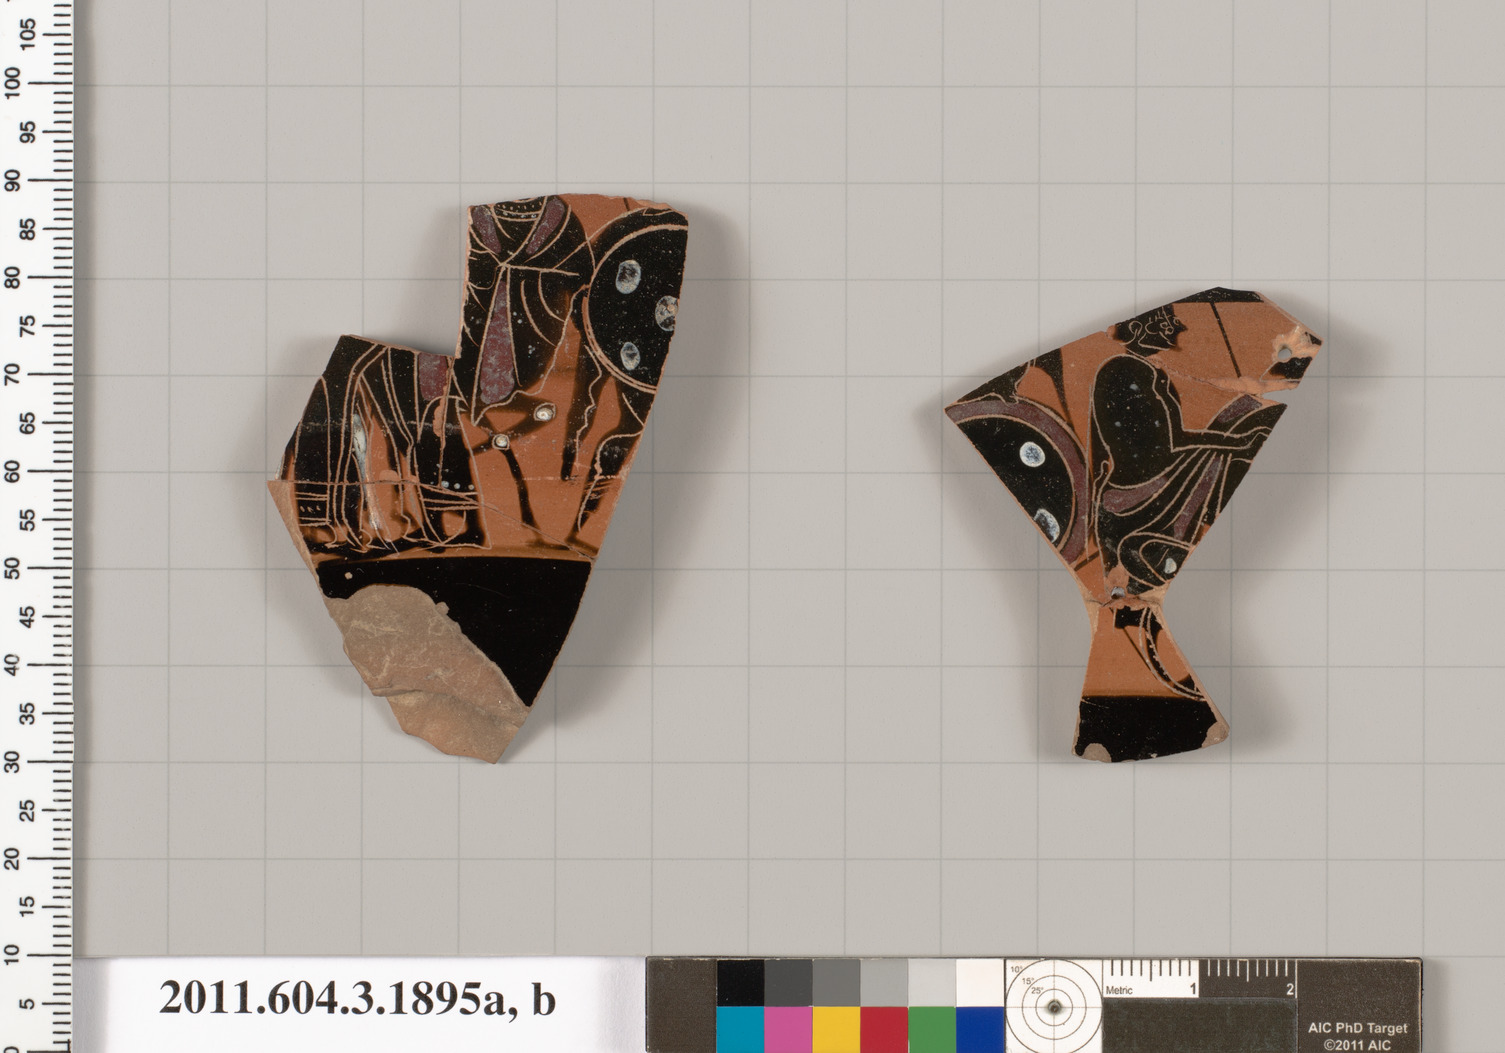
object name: kylix fragment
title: Terracotta fragments of a kylix: Band cup (drinking cup)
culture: greek, attic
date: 550-526 BCE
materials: terracotta